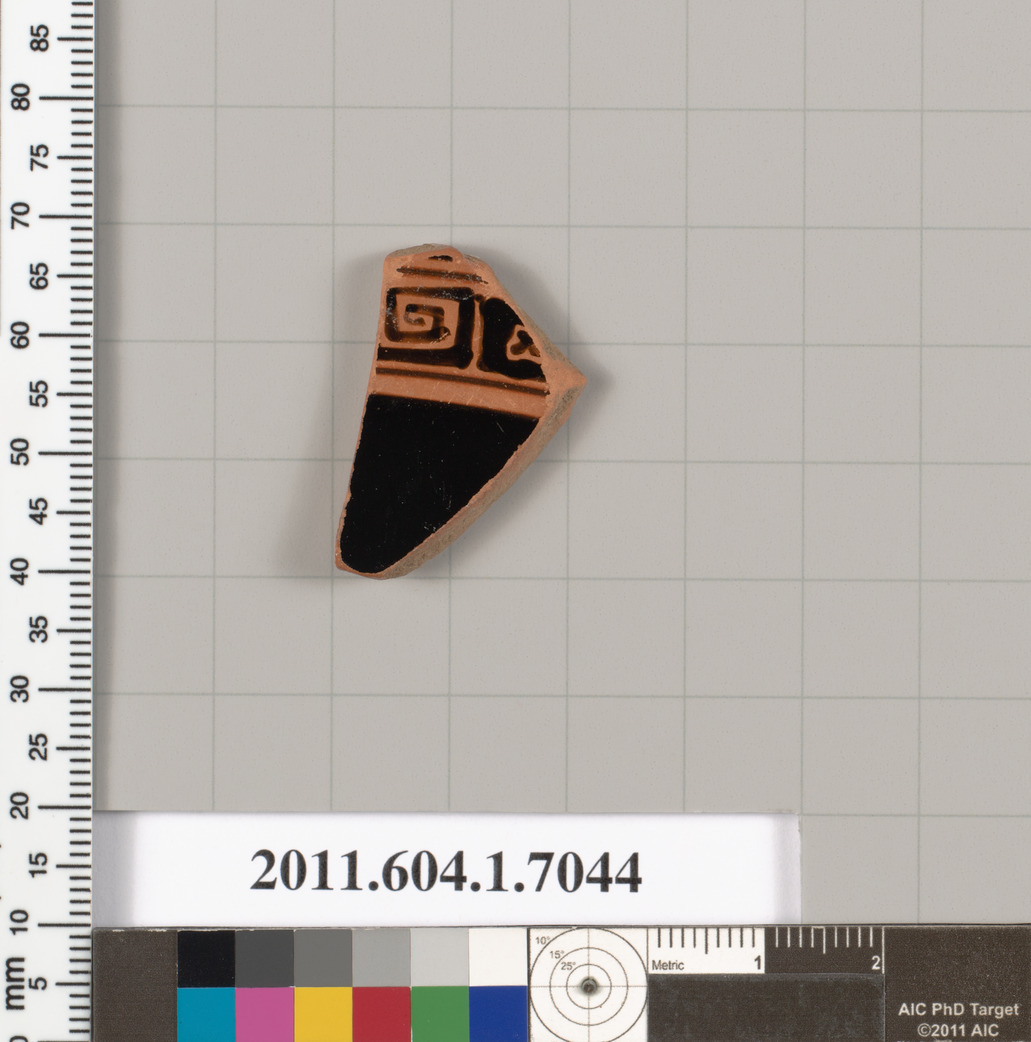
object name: kylix fragment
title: Terracotta fragment of a kylix (drinking cup)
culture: greek, attic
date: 500-480 BCE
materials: terracotta